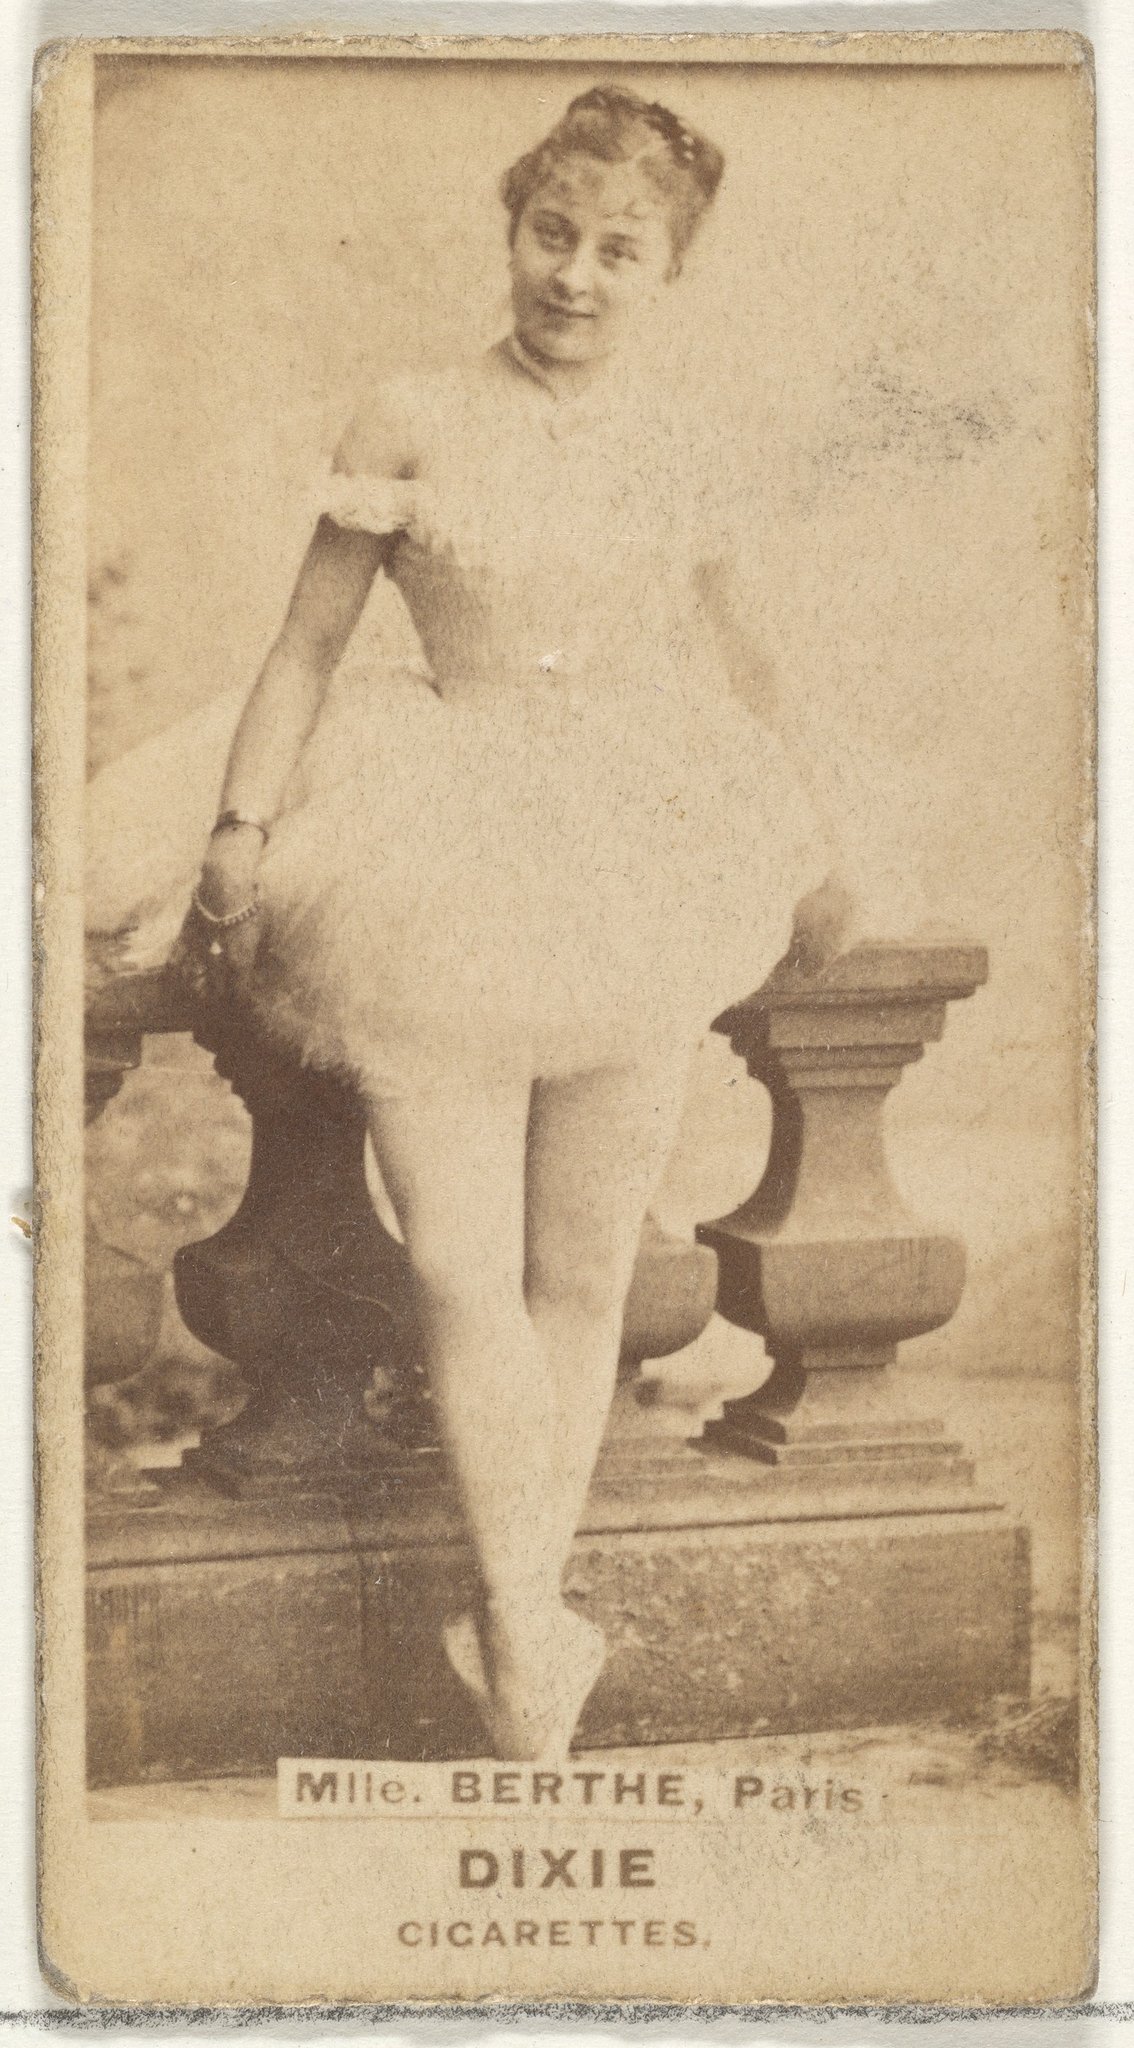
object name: photograph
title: Mlle. Berthe, Paris, from the Actors and Actresses series (N45, Type 1) for Dixie Cigarettes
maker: allen & ginter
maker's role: publisher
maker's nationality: american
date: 1888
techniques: albumen silver print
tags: portraits,women,actresses